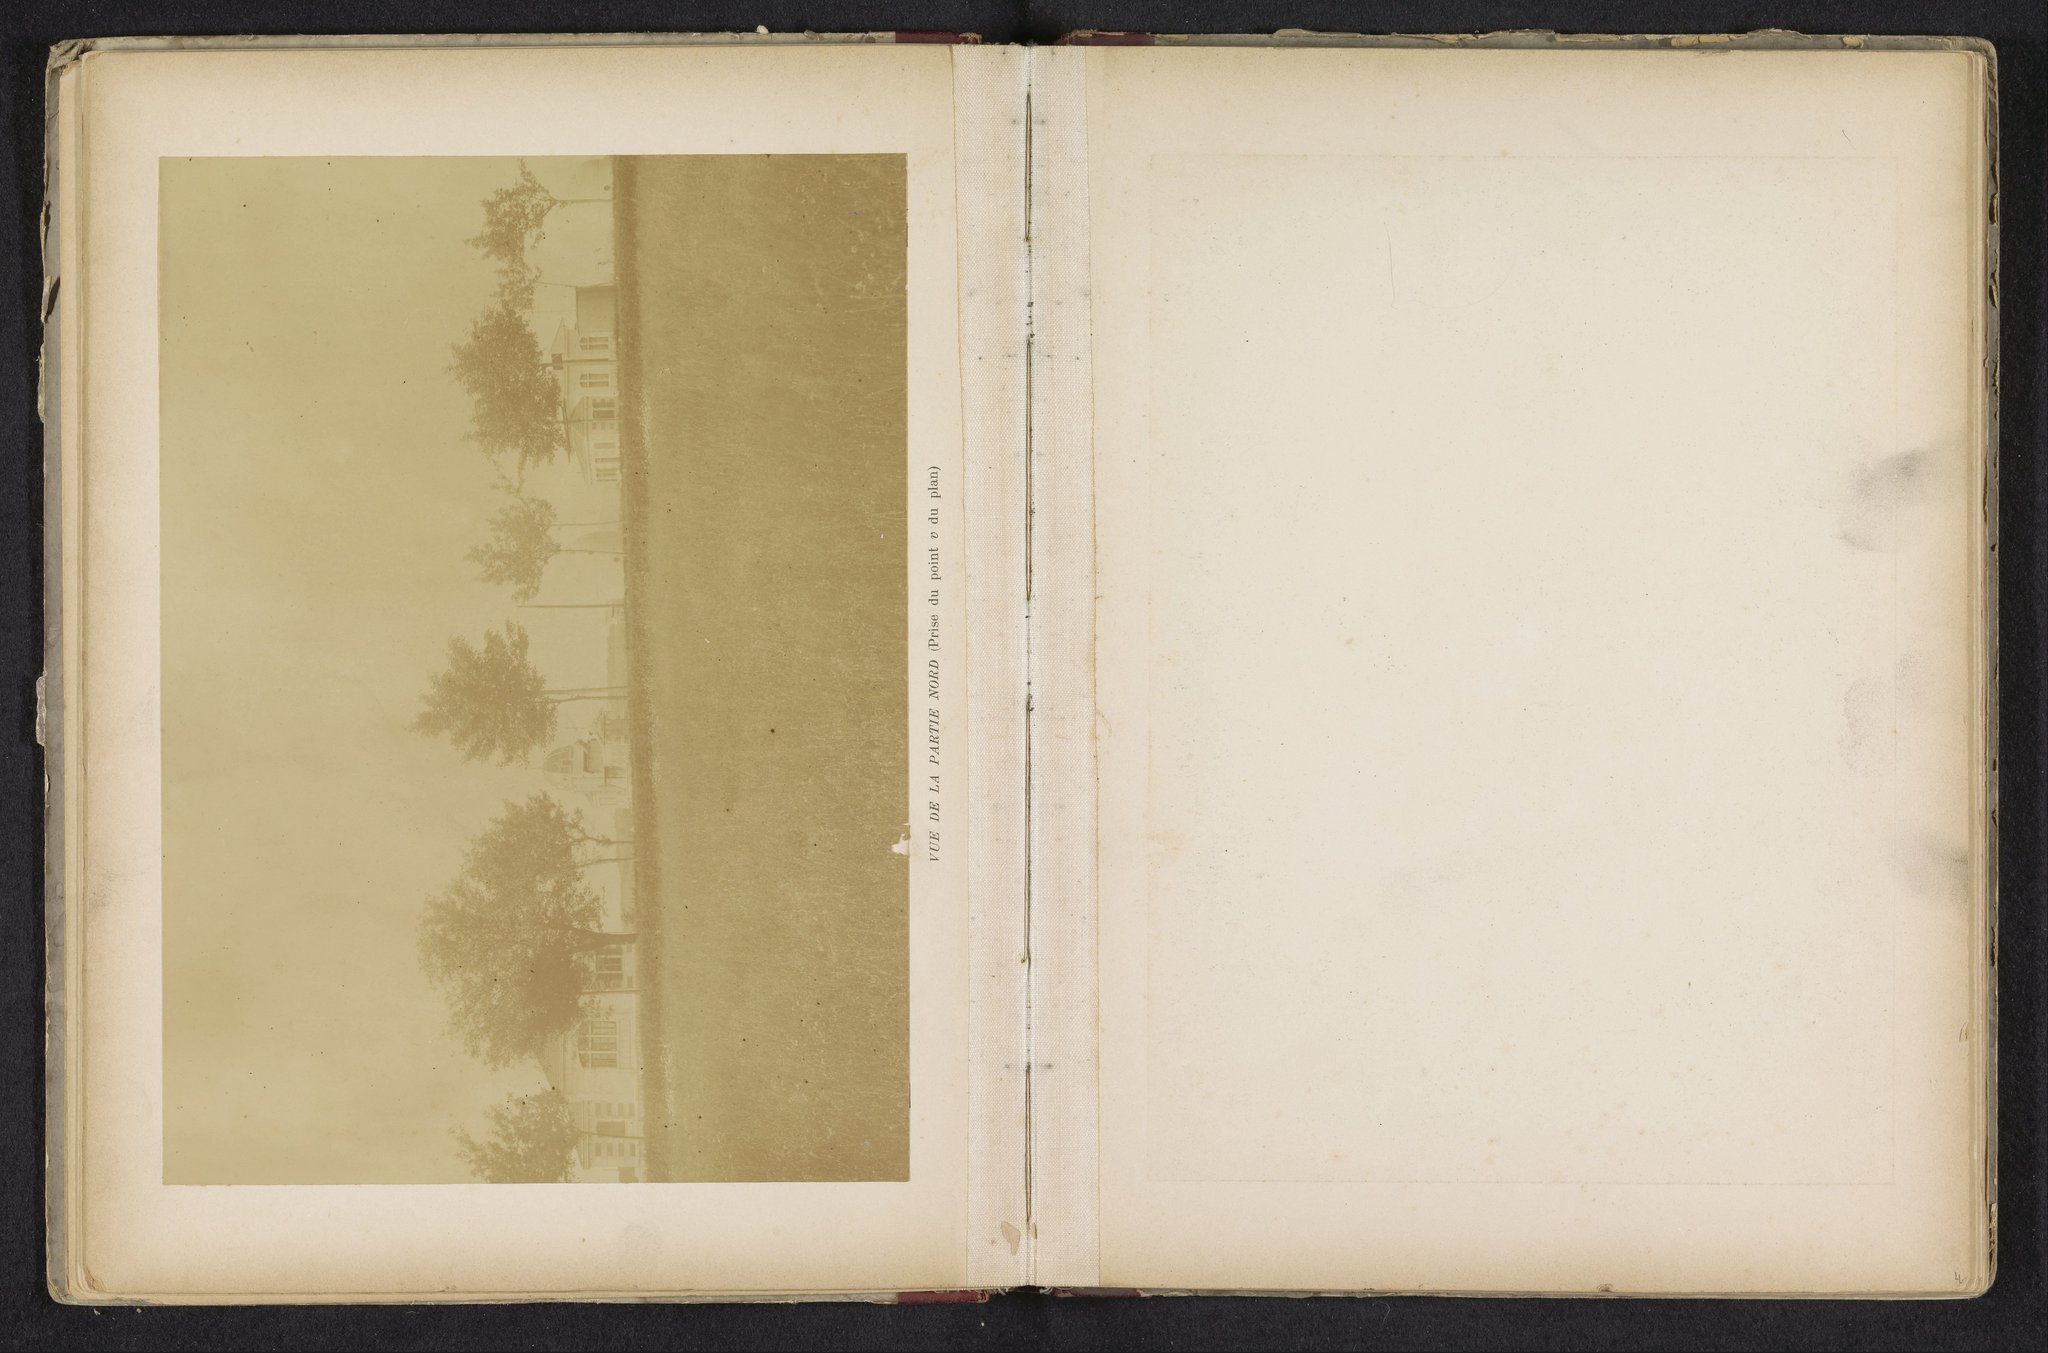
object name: photograph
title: Gezicht op gebouwen van het observatorium in Besançon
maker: m. lebeuf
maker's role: fotograaf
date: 1882-1892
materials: photographic support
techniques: gelatin silver print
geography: besançon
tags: observatory (~ astronomy), meteorological observatory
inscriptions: inscription: ‘(Prise du point v du plan)’